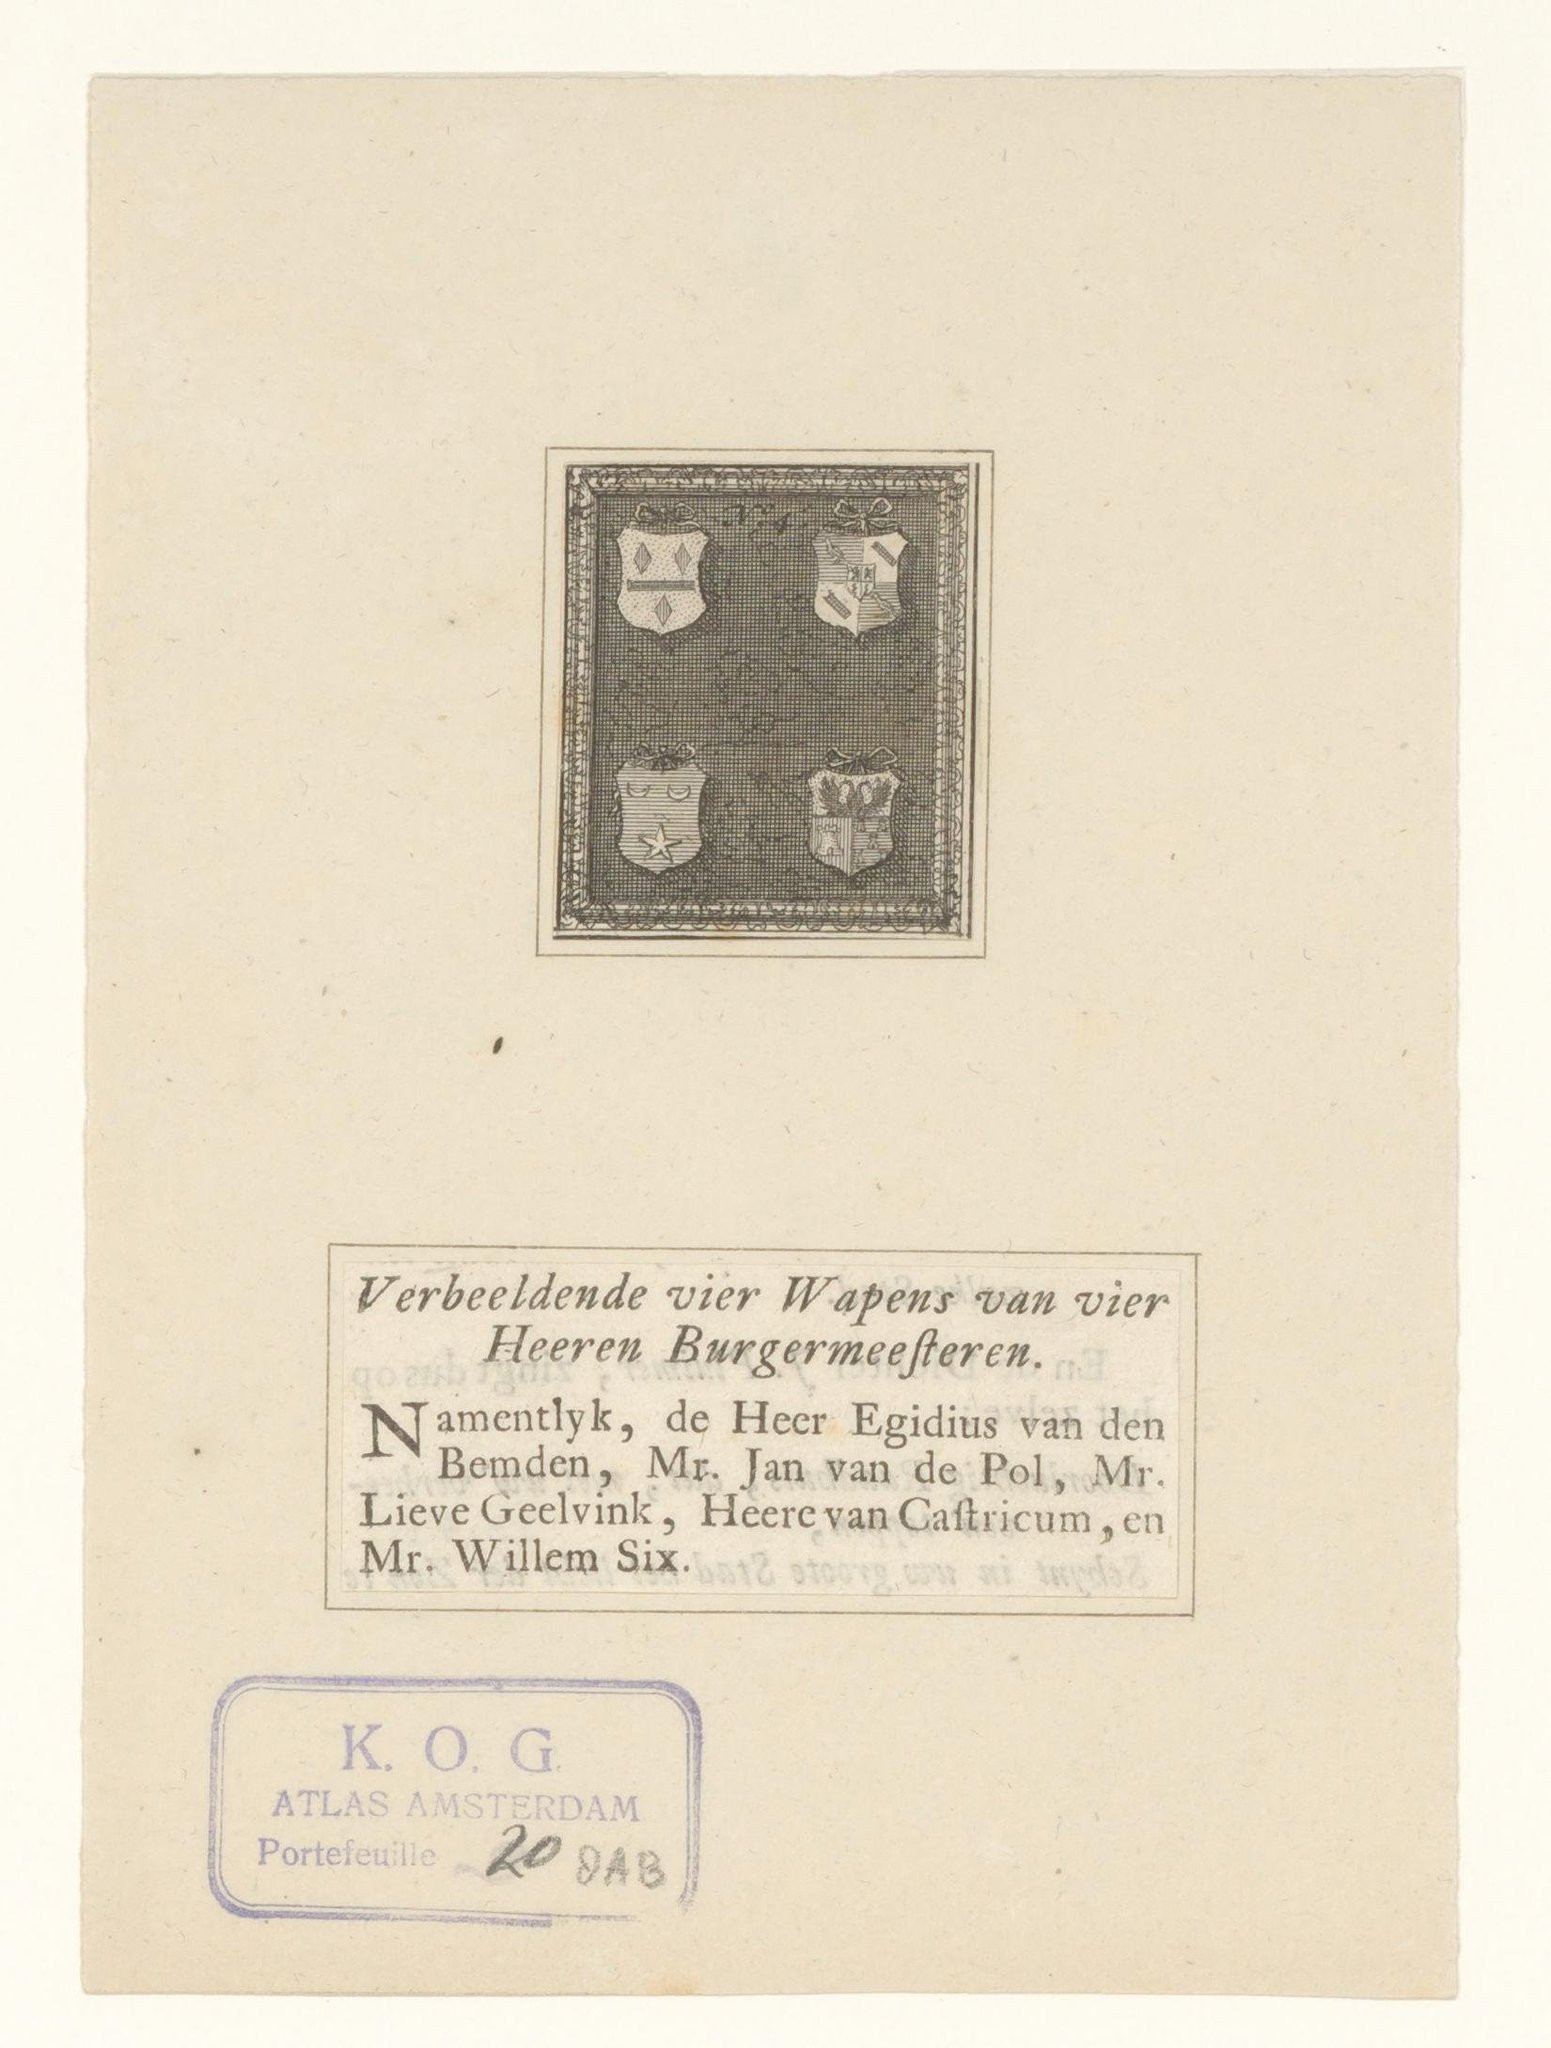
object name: print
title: Wapens van Aegidius van den Bempden, Jan van de Poll, Lieve Geelvinck en Willem Six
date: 1736-1744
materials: paper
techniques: etching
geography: haarlem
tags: amsterdam, lieve geelvinck, mayor, armorial bearing, heraldry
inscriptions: collector's mark: Lugt 1641b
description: Centraal bovenaan genummerd: No. 4. Onder de prent is een verklarend bijschrift van de prent geplakt. Onderwerpsrubriek binnen de Atlas Amsterdam: Wapens regeringsleden.